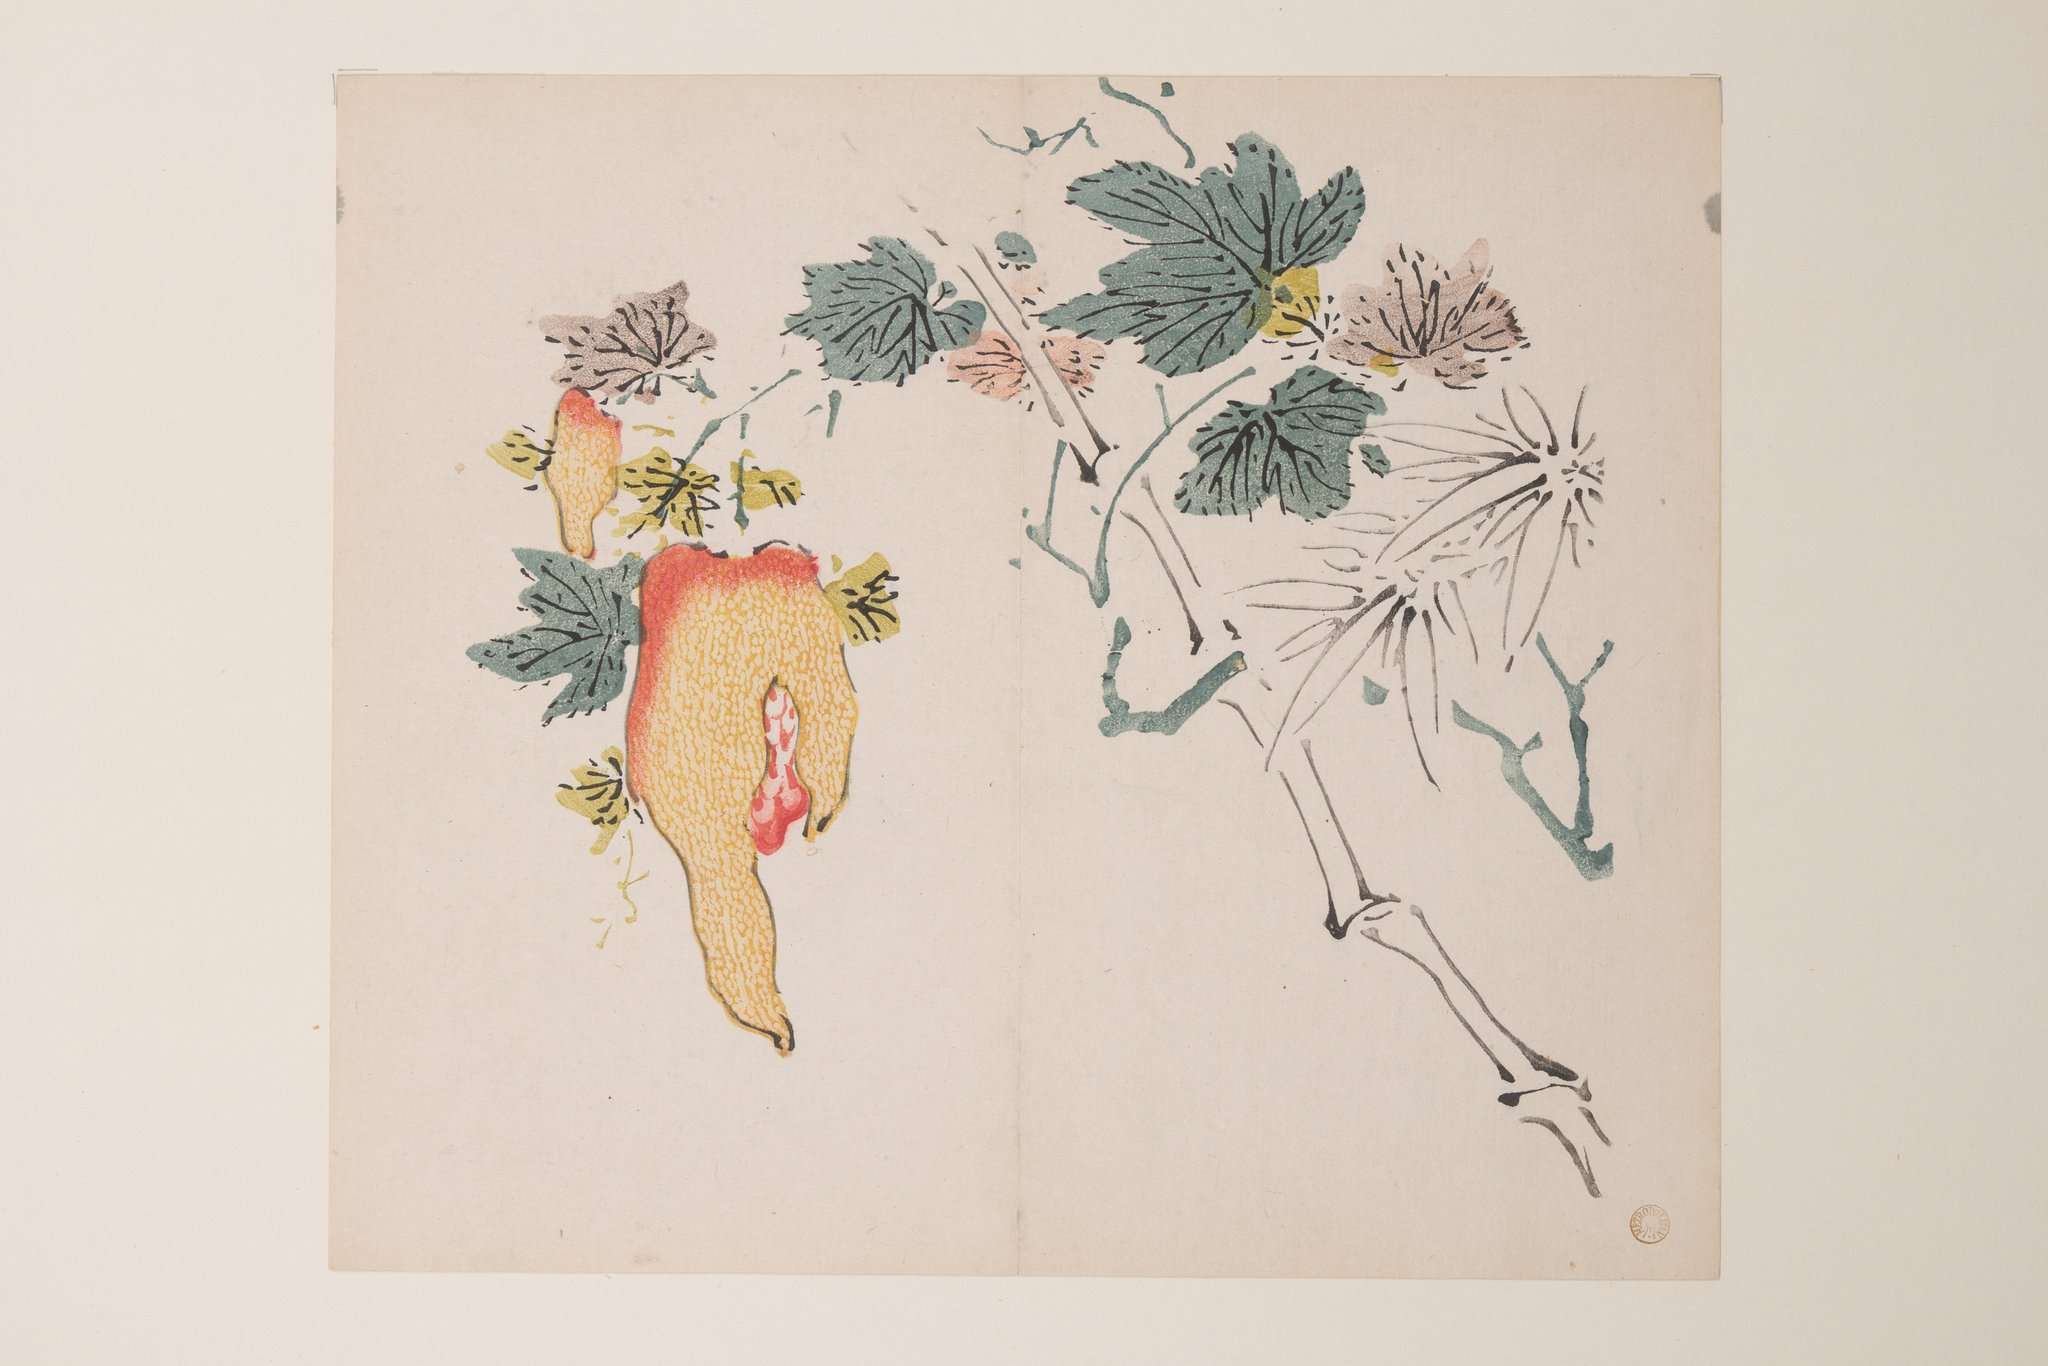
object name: print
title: Page from the Ten Bamboo Studio Manual of Painting and Calligraphy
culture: chinese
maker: hu zhengyan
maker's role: artist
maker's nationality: chinese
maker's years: 1584-1634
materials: ink, paper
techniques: printing